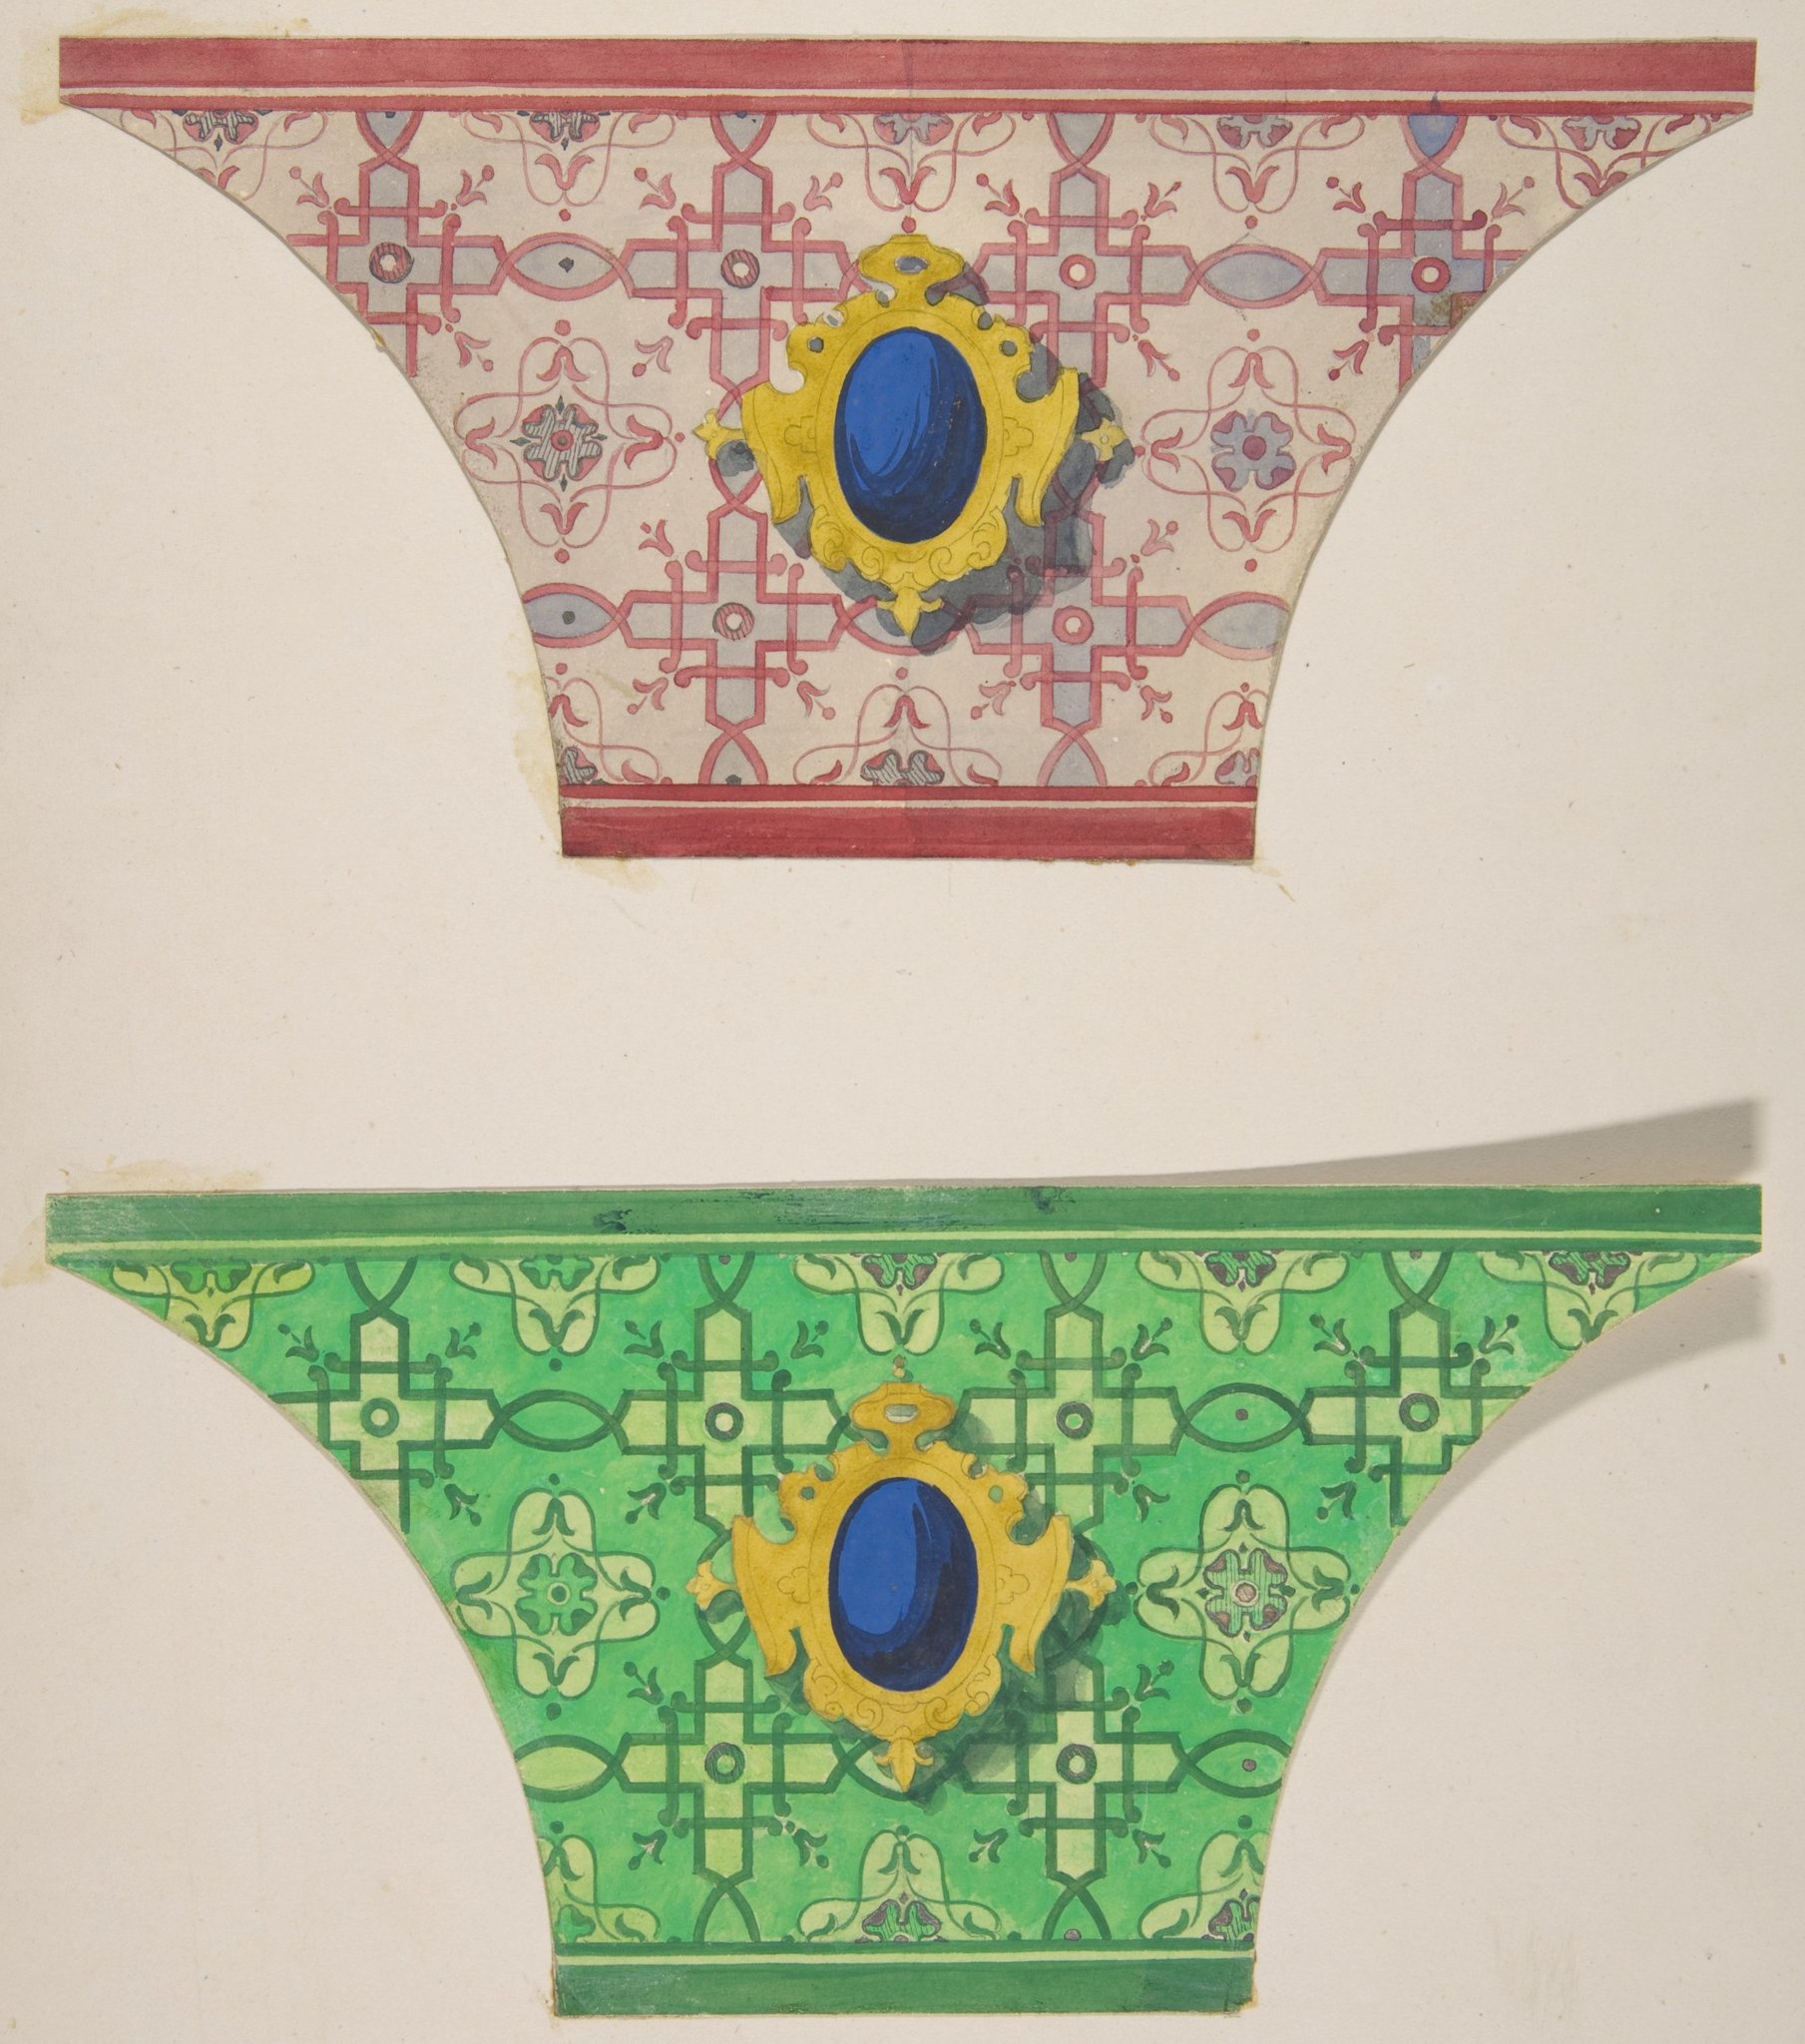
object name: drawing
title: Two designs for the painted decoration of ceiling coves with cartouches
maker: jules-edmond-charles lachaise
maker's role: artist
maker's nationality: french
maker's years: 1897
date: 1830-1897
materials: gouache, graphite, watercolor, paper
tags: ceilings